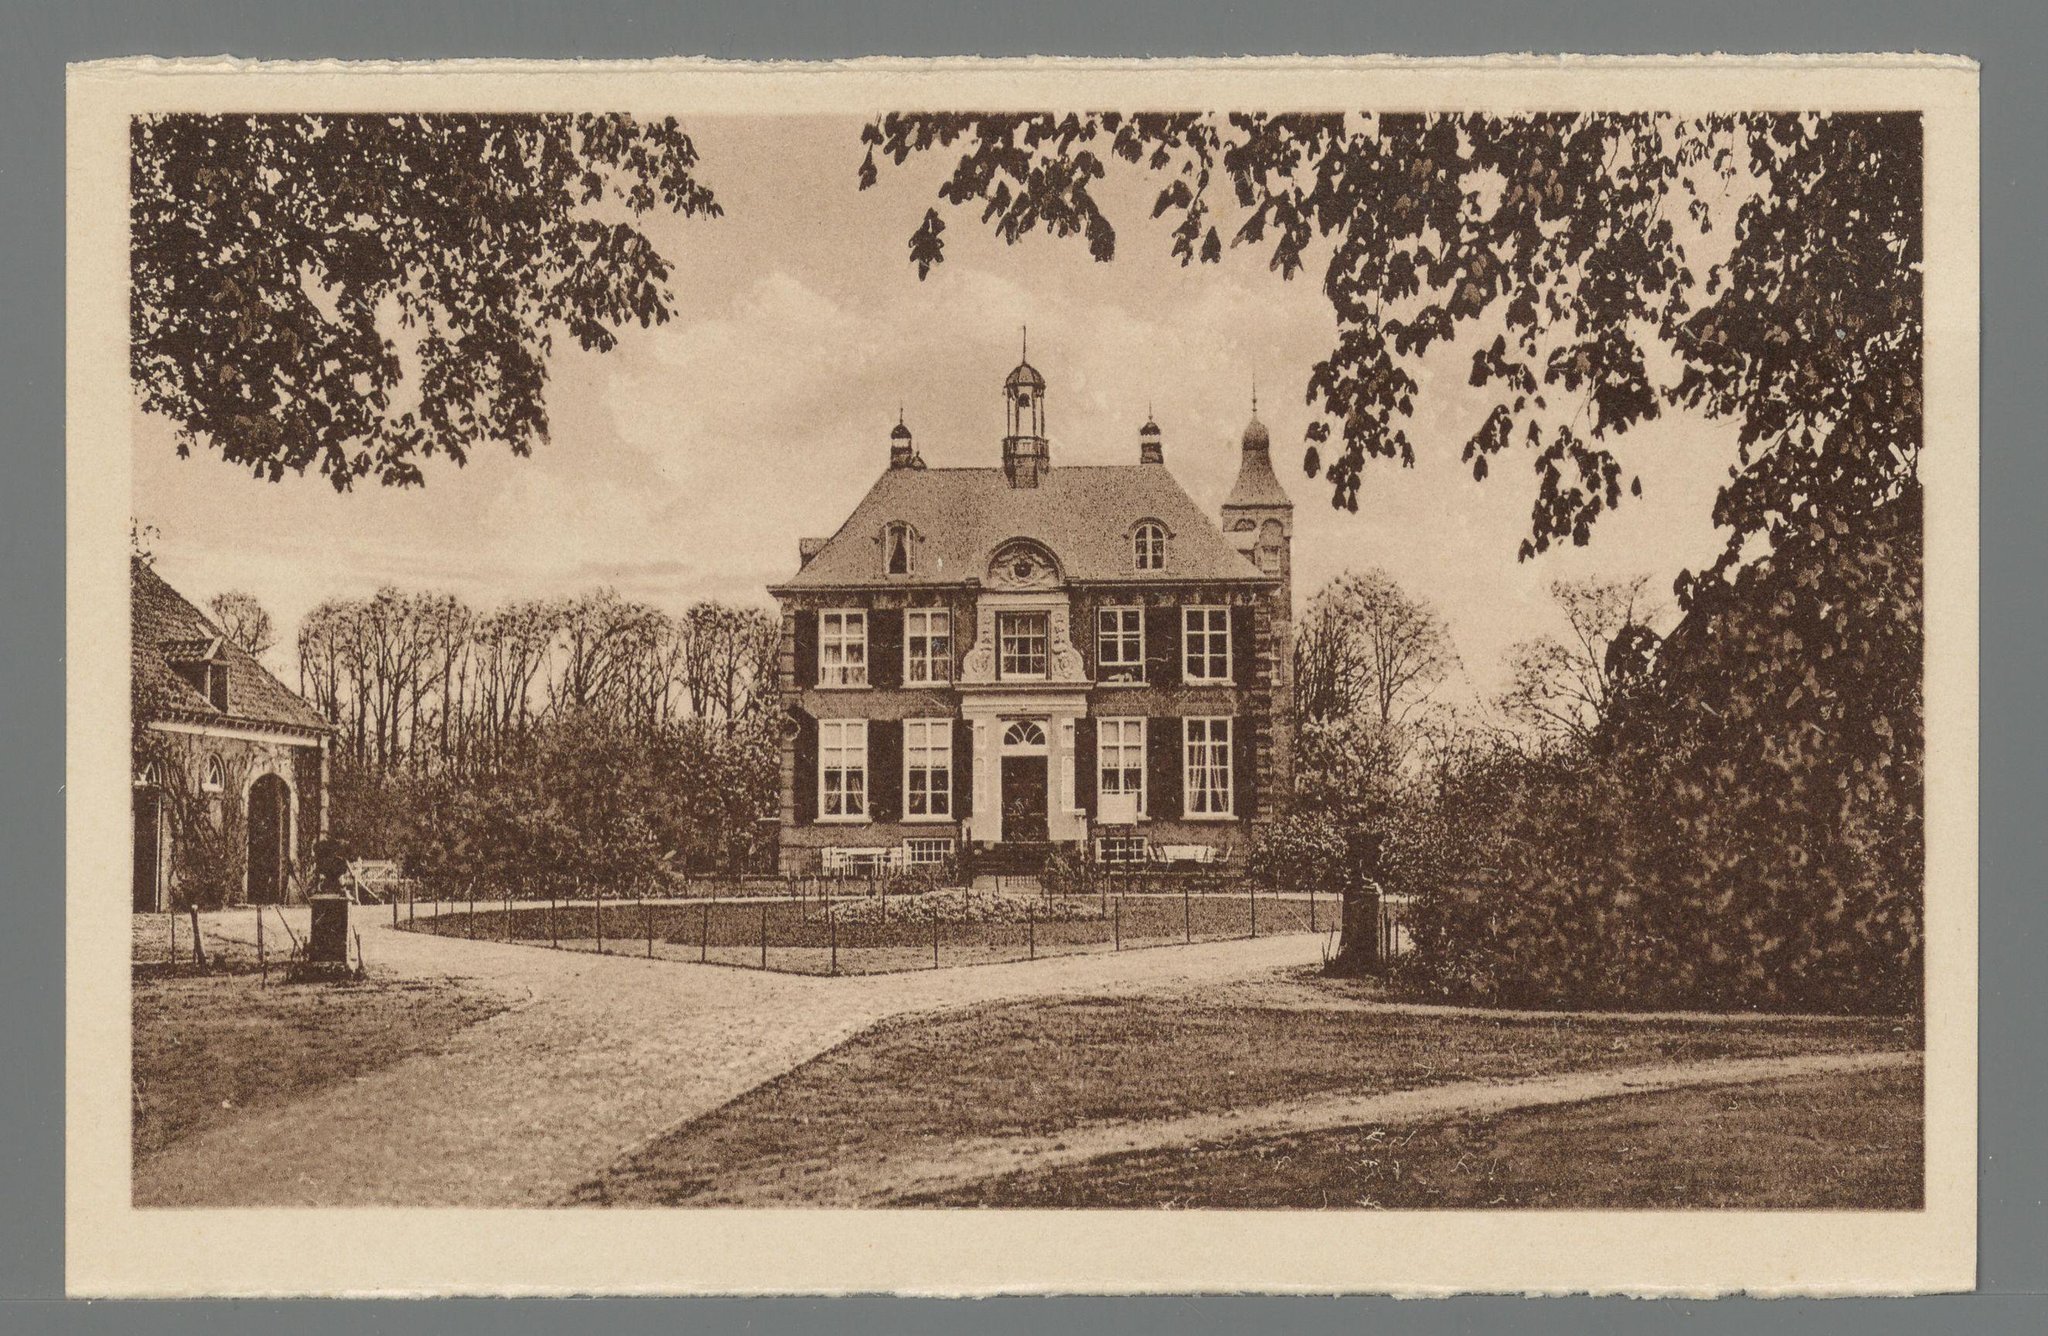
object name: ansichtkaart, prentbriefkaart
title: Kasteel No. VI. Huize Onstein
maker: Anonymous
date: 1926-1930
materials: cardboard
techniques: photograph, writing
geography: vorden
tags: villa